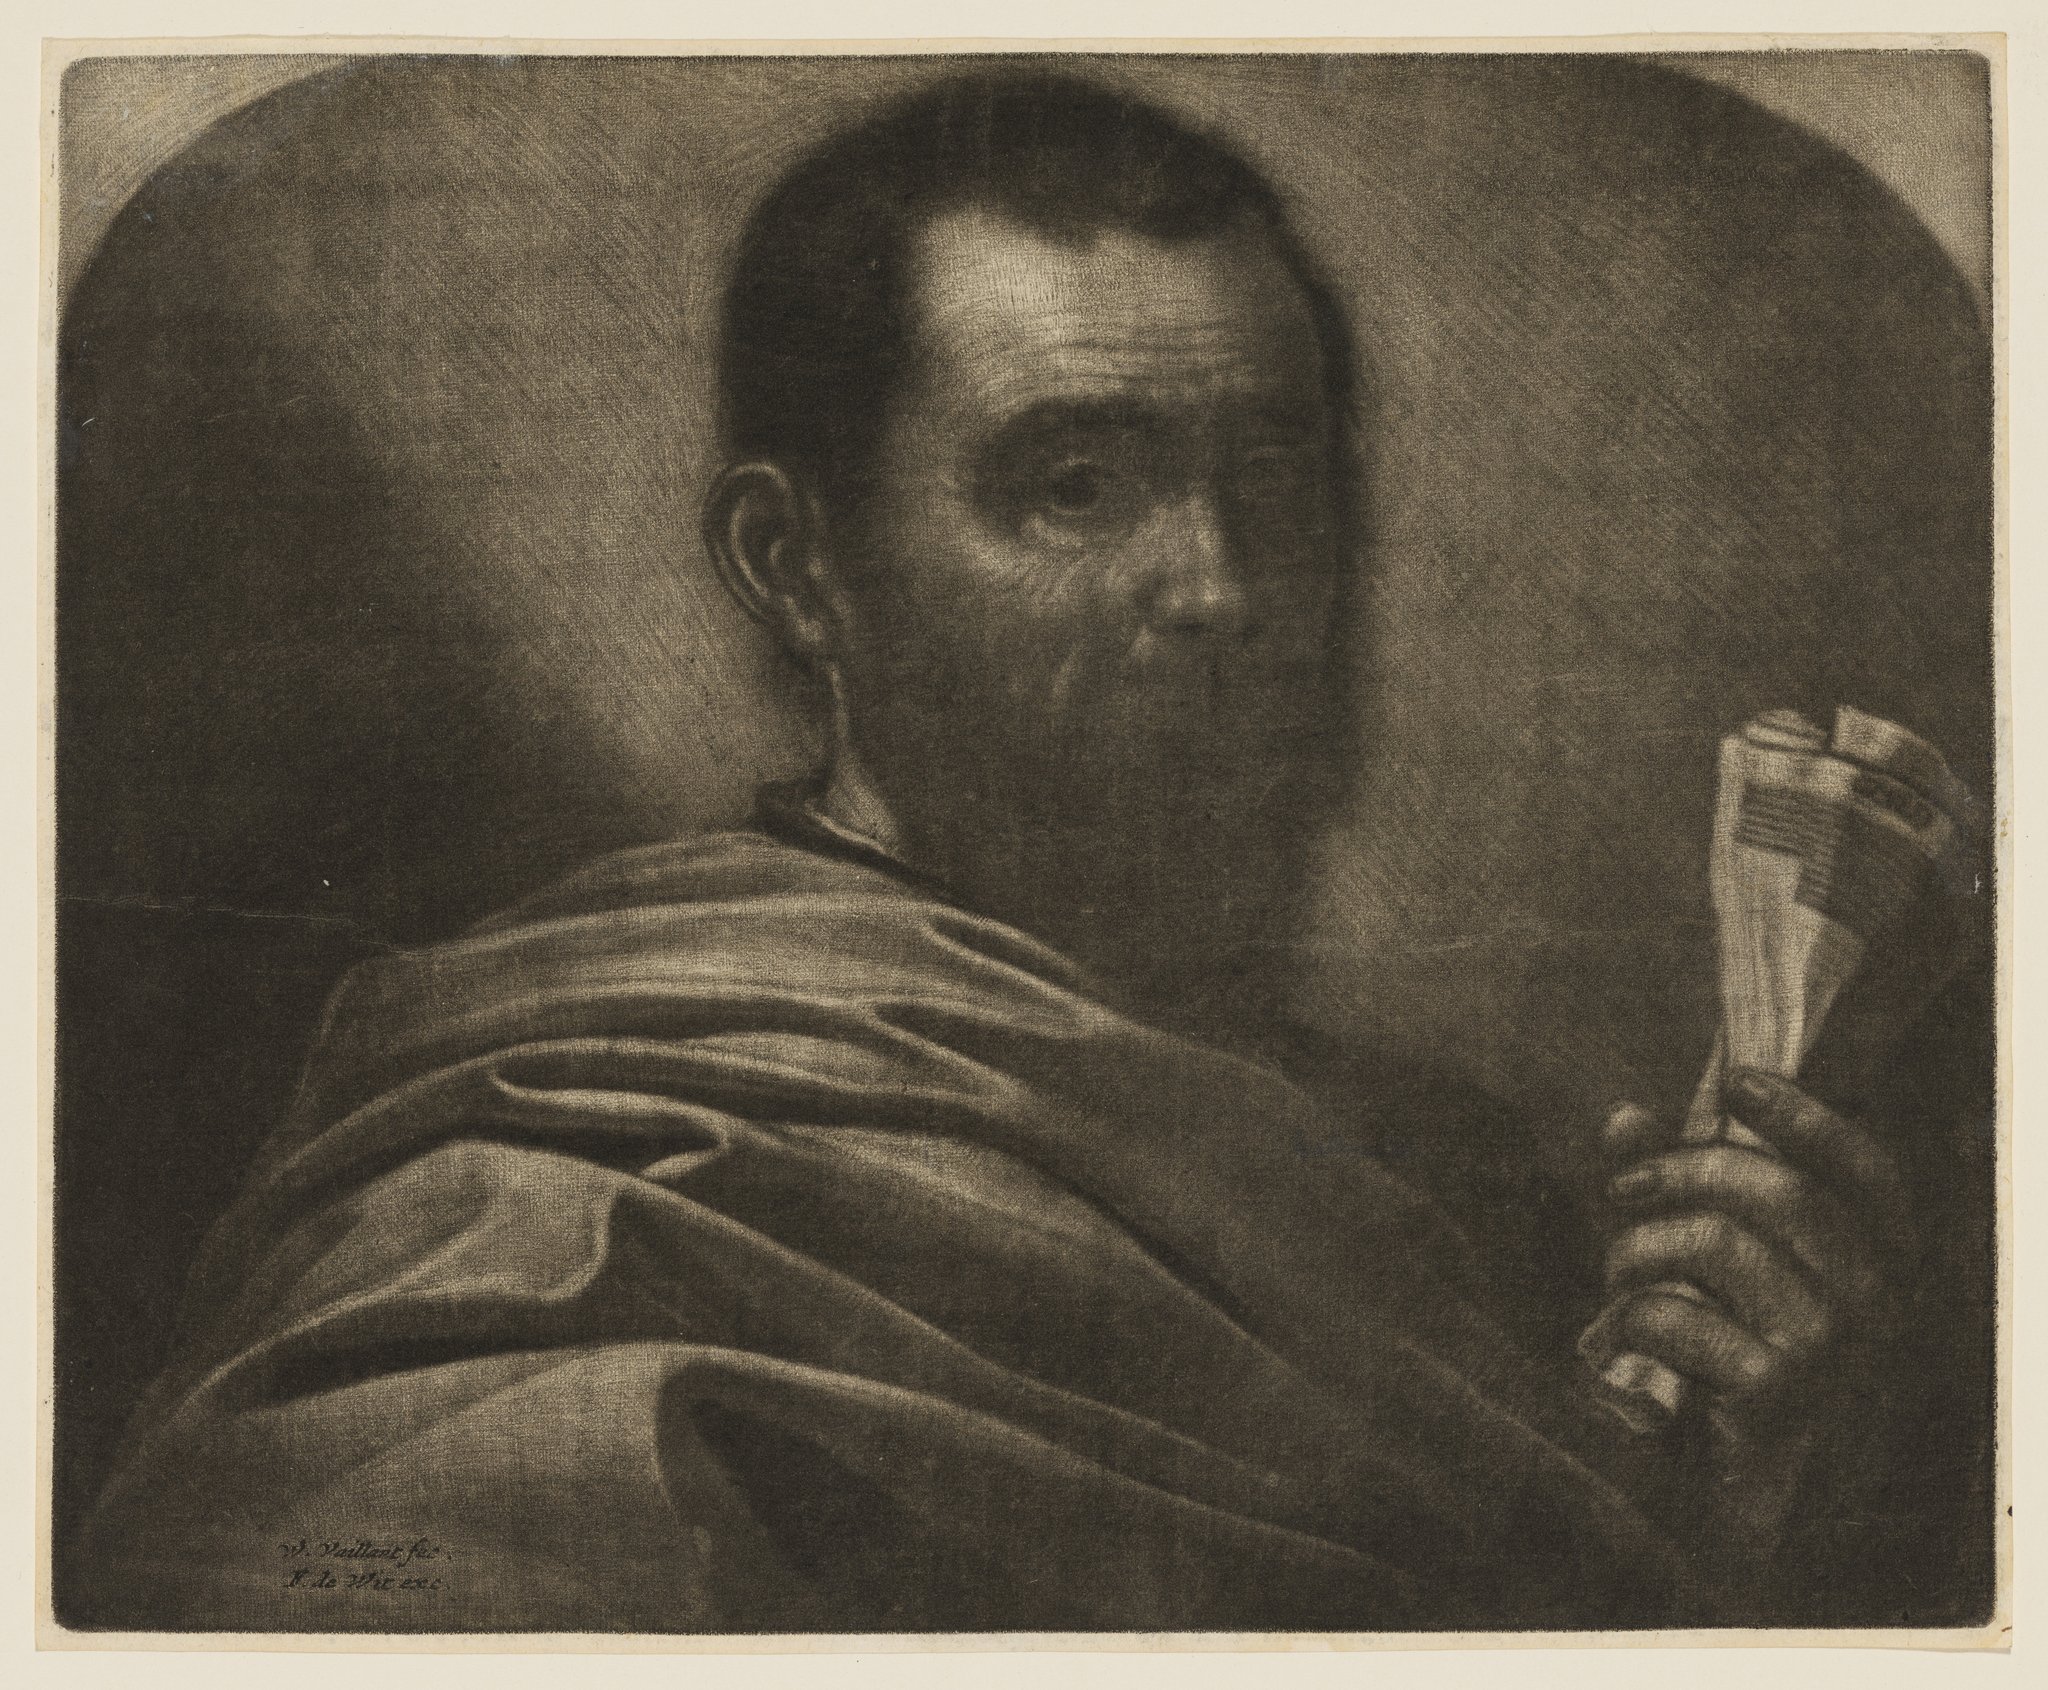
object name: print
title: Man Holding a Scroll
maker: wallerant vaillant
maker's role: artist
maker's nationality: dutch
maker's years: 1623-1677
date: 1634-1666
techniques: mezzotint